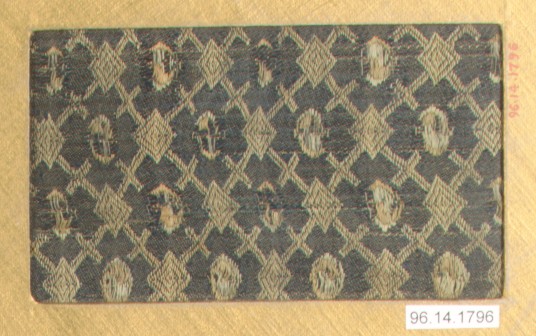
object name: piece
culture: japanese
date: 1701-1900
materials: silk